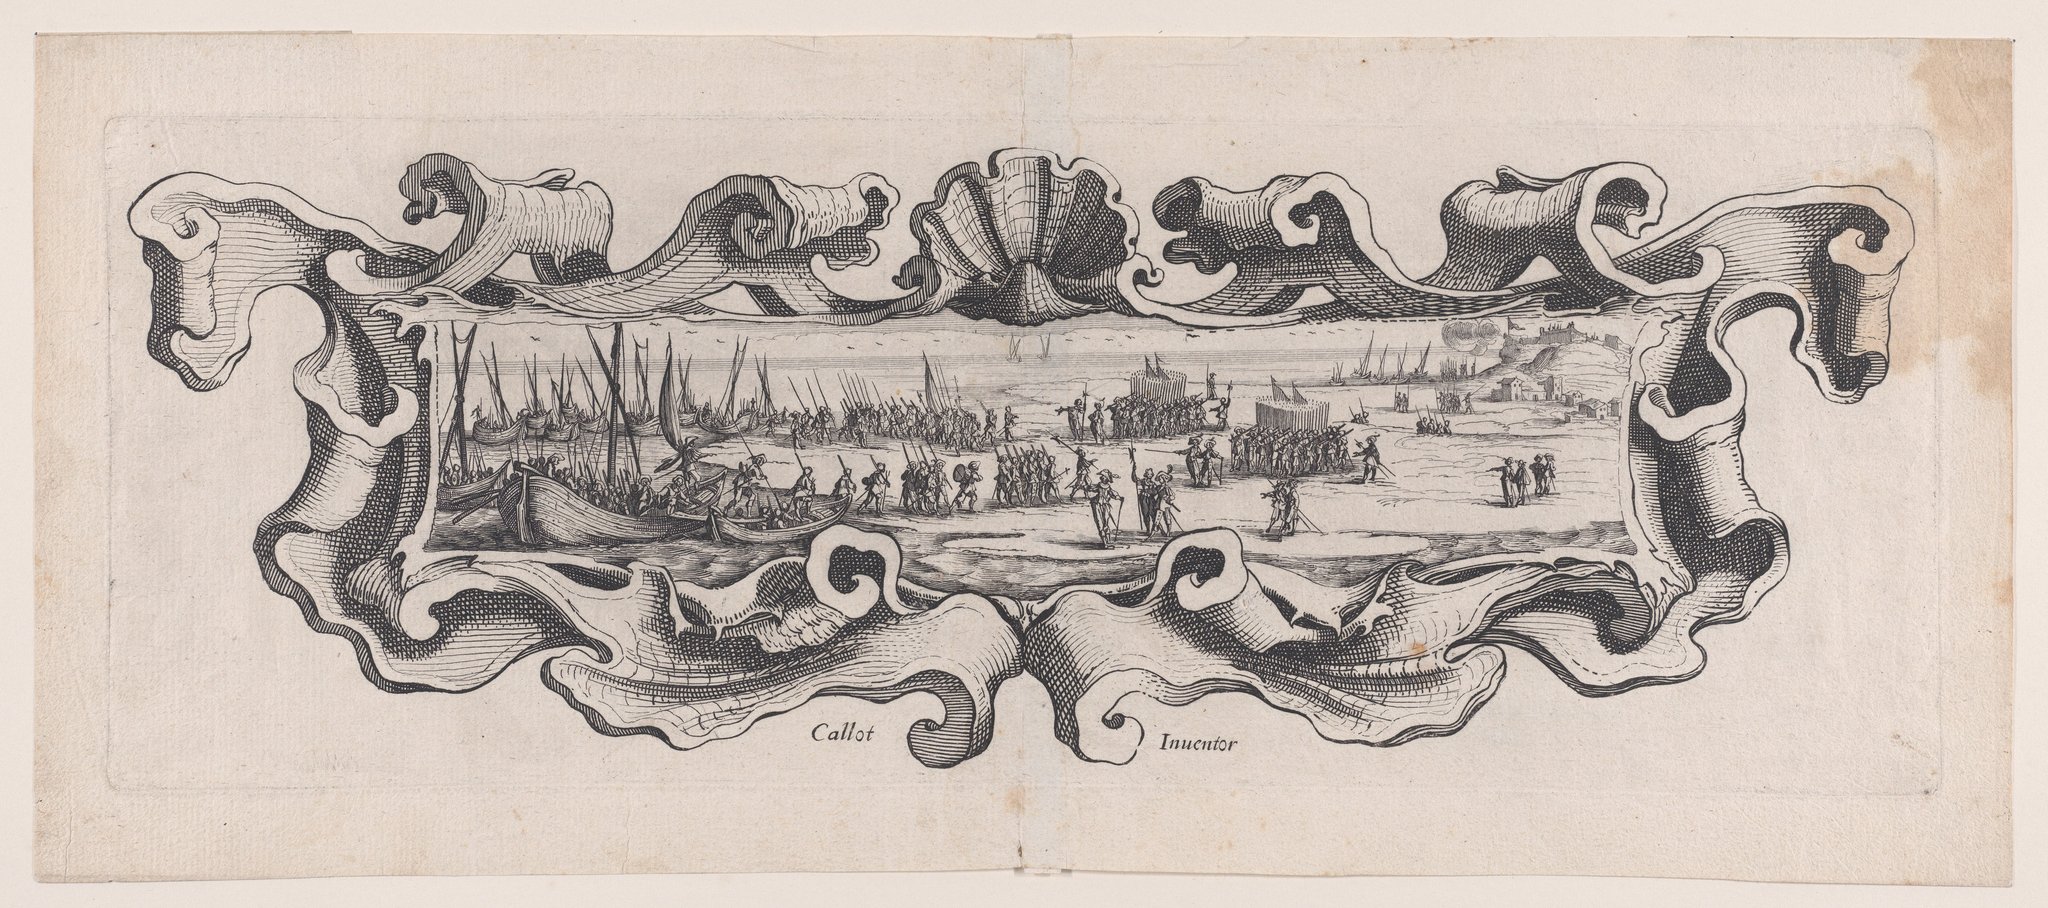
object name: print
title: Reverse Copy of Le Débarquement des Troupes (The Landing of the Troops)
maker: Anonymous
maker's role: artist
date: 1601-1700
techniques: engraving, etching